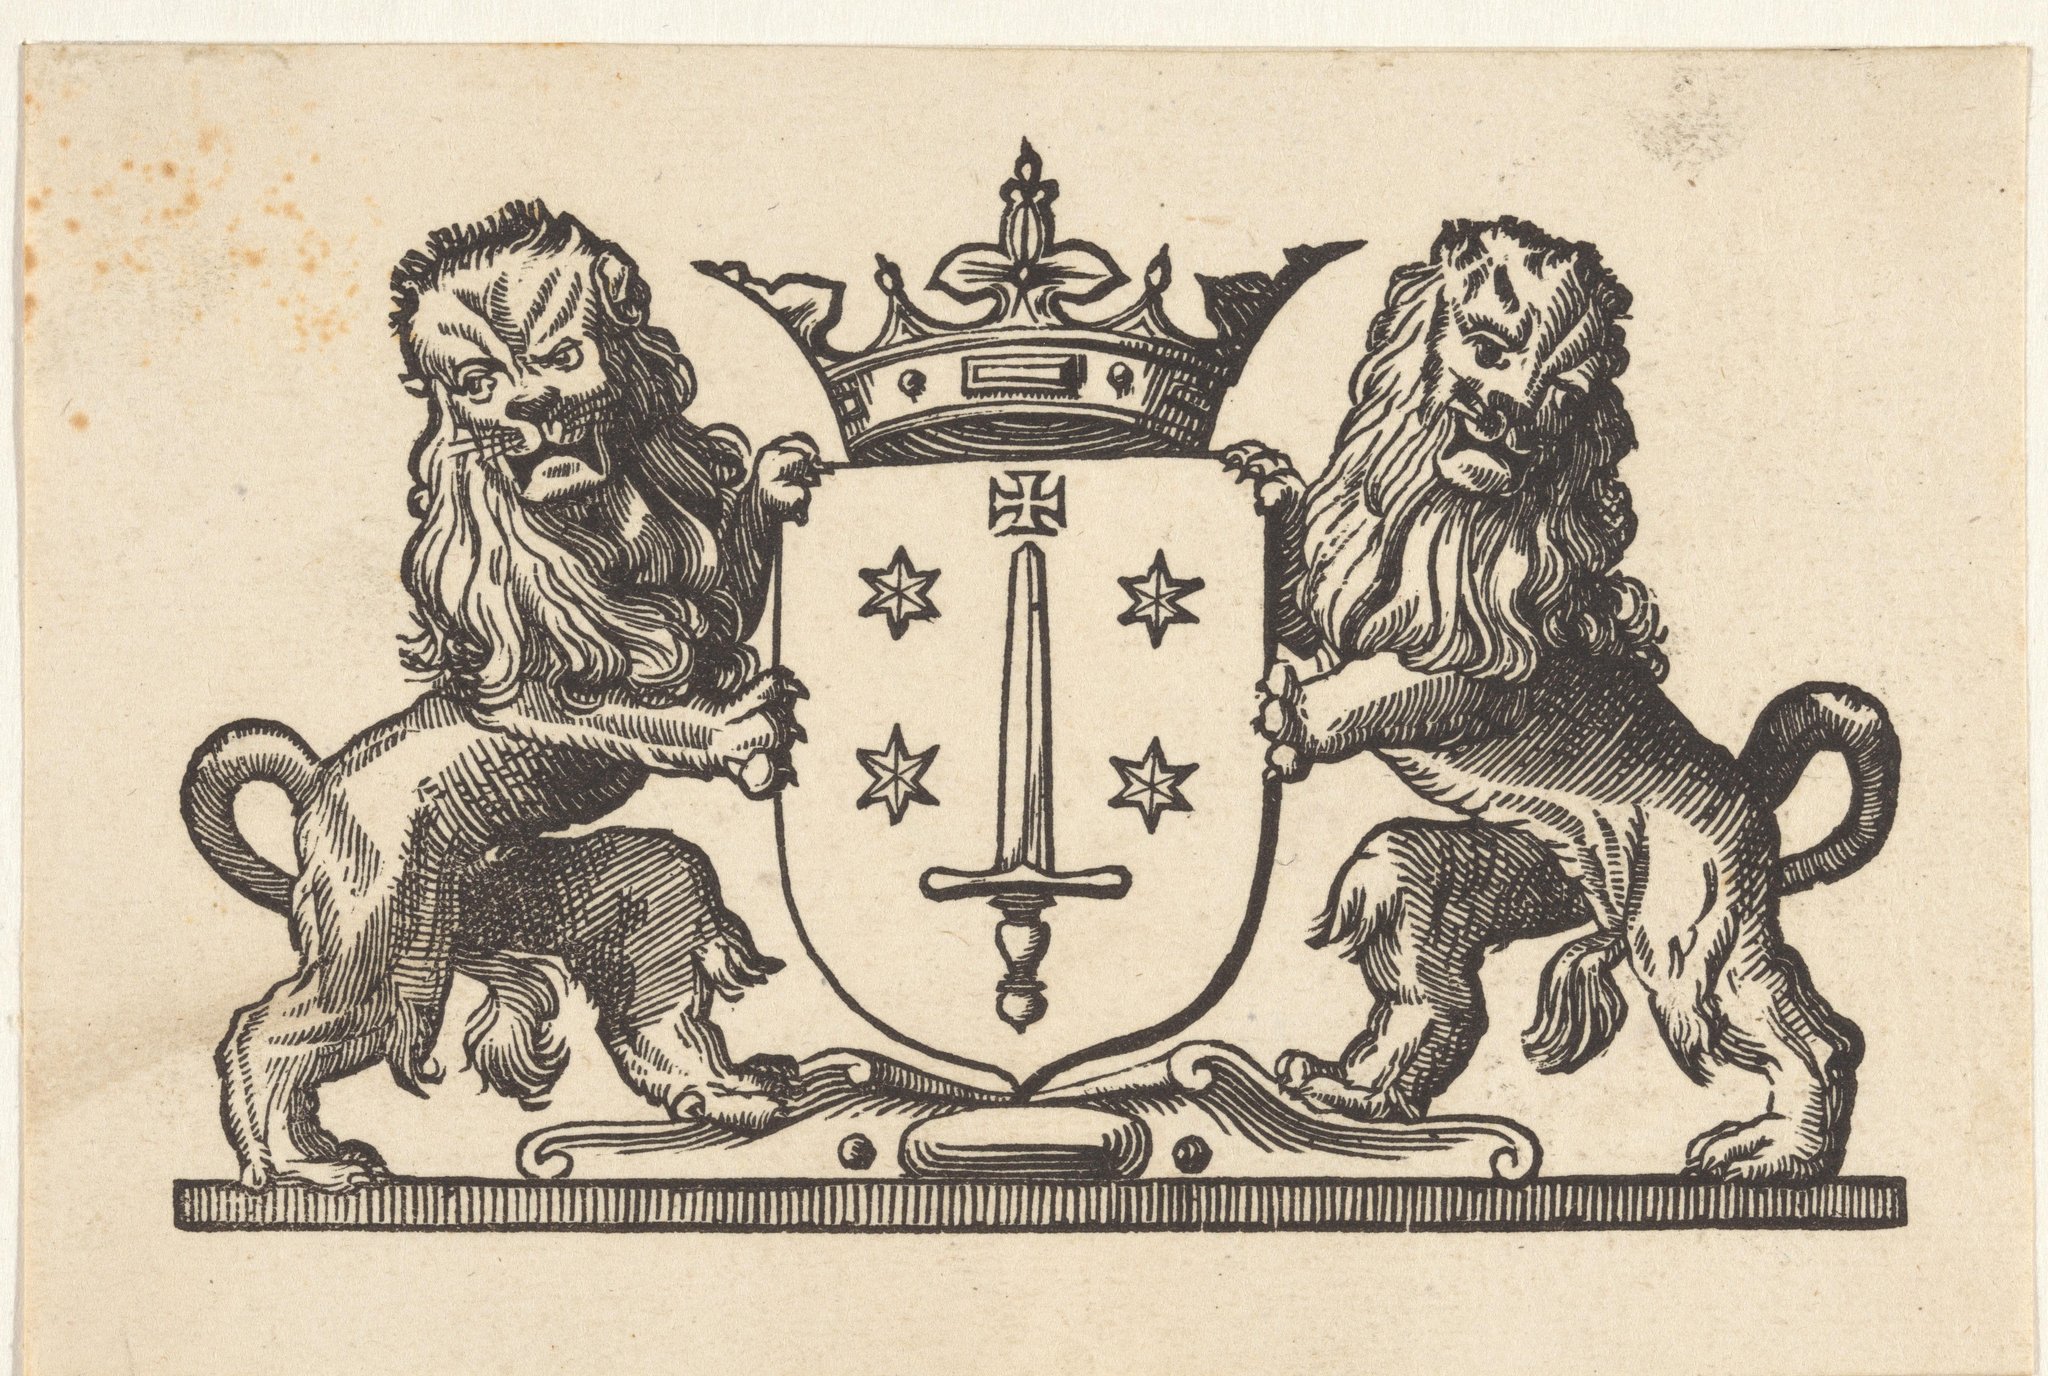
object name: print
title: Vignet met het wapen van de stad Haarlem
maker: Anonymous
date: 1600-1699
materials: paper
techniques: woodcut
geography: netherlands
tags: coat of arms (as symbol of the state, etc.) (+ city; municipal), vignette, haarlem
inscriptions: collector's mark: Lugt 240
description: Het wapen van de stad Haarlem met een kroon en twee leeuwen.